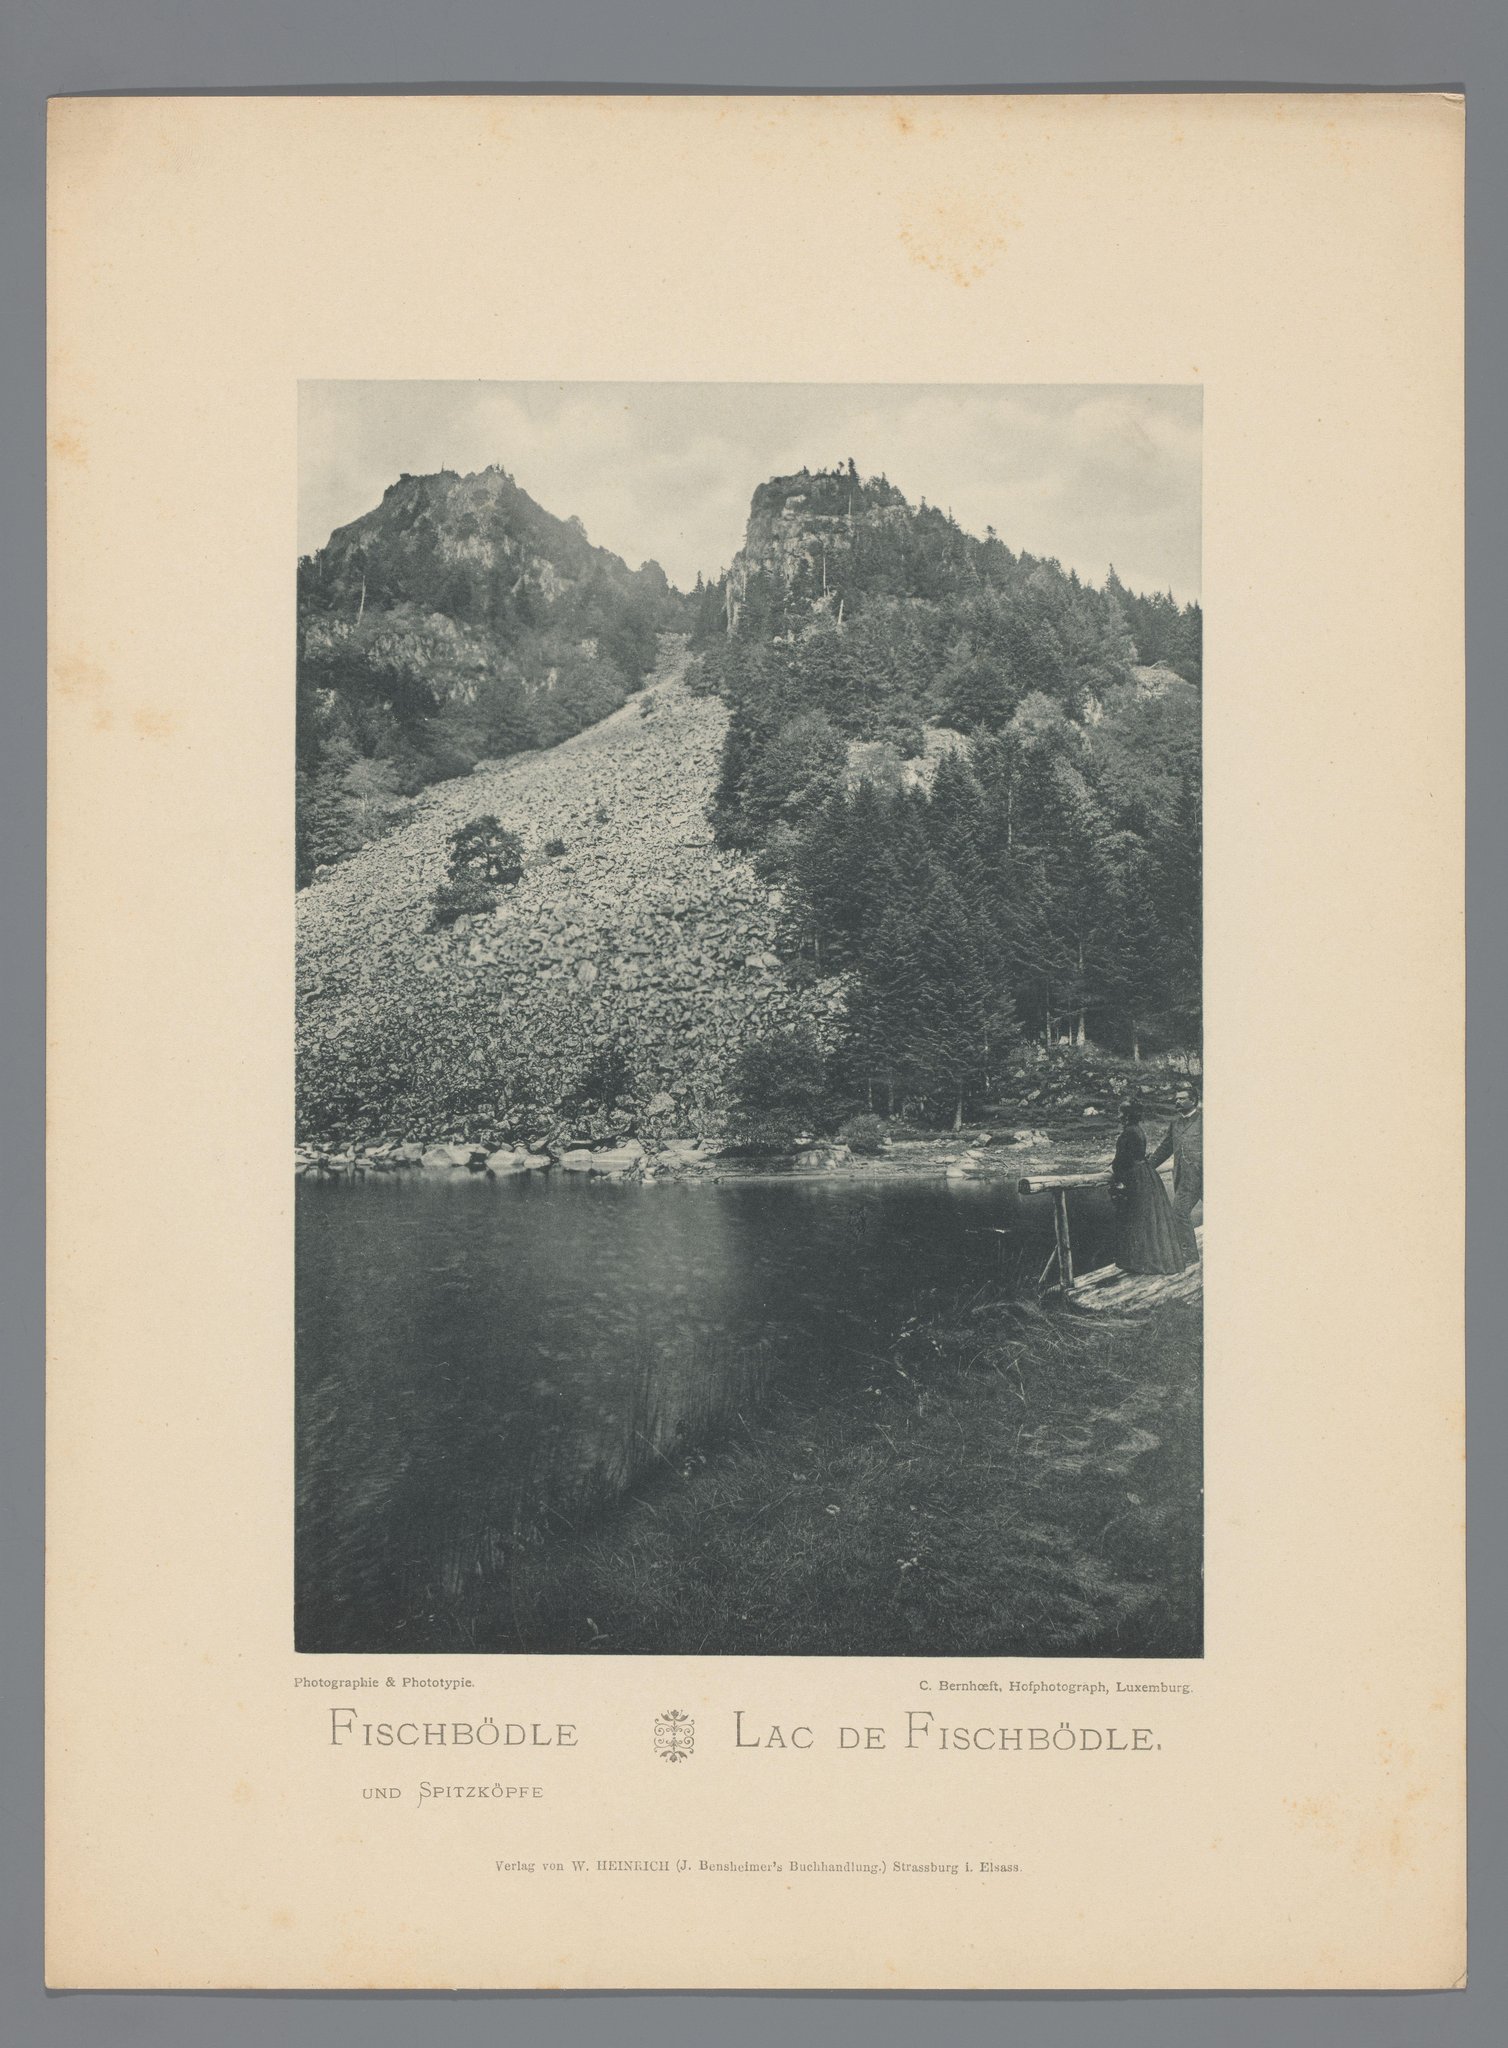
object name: photomechanical print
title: Fischbödle, Lac de Fischbödle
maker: charles bernhoeft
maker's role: publisher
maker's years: 1859-1933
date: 1889-1894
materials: paper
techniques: photograph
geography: straatsburg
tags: lake (+ landscape with figures, staffage)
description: Deze prent maakt deel uit van een omslag met 100 prenten.